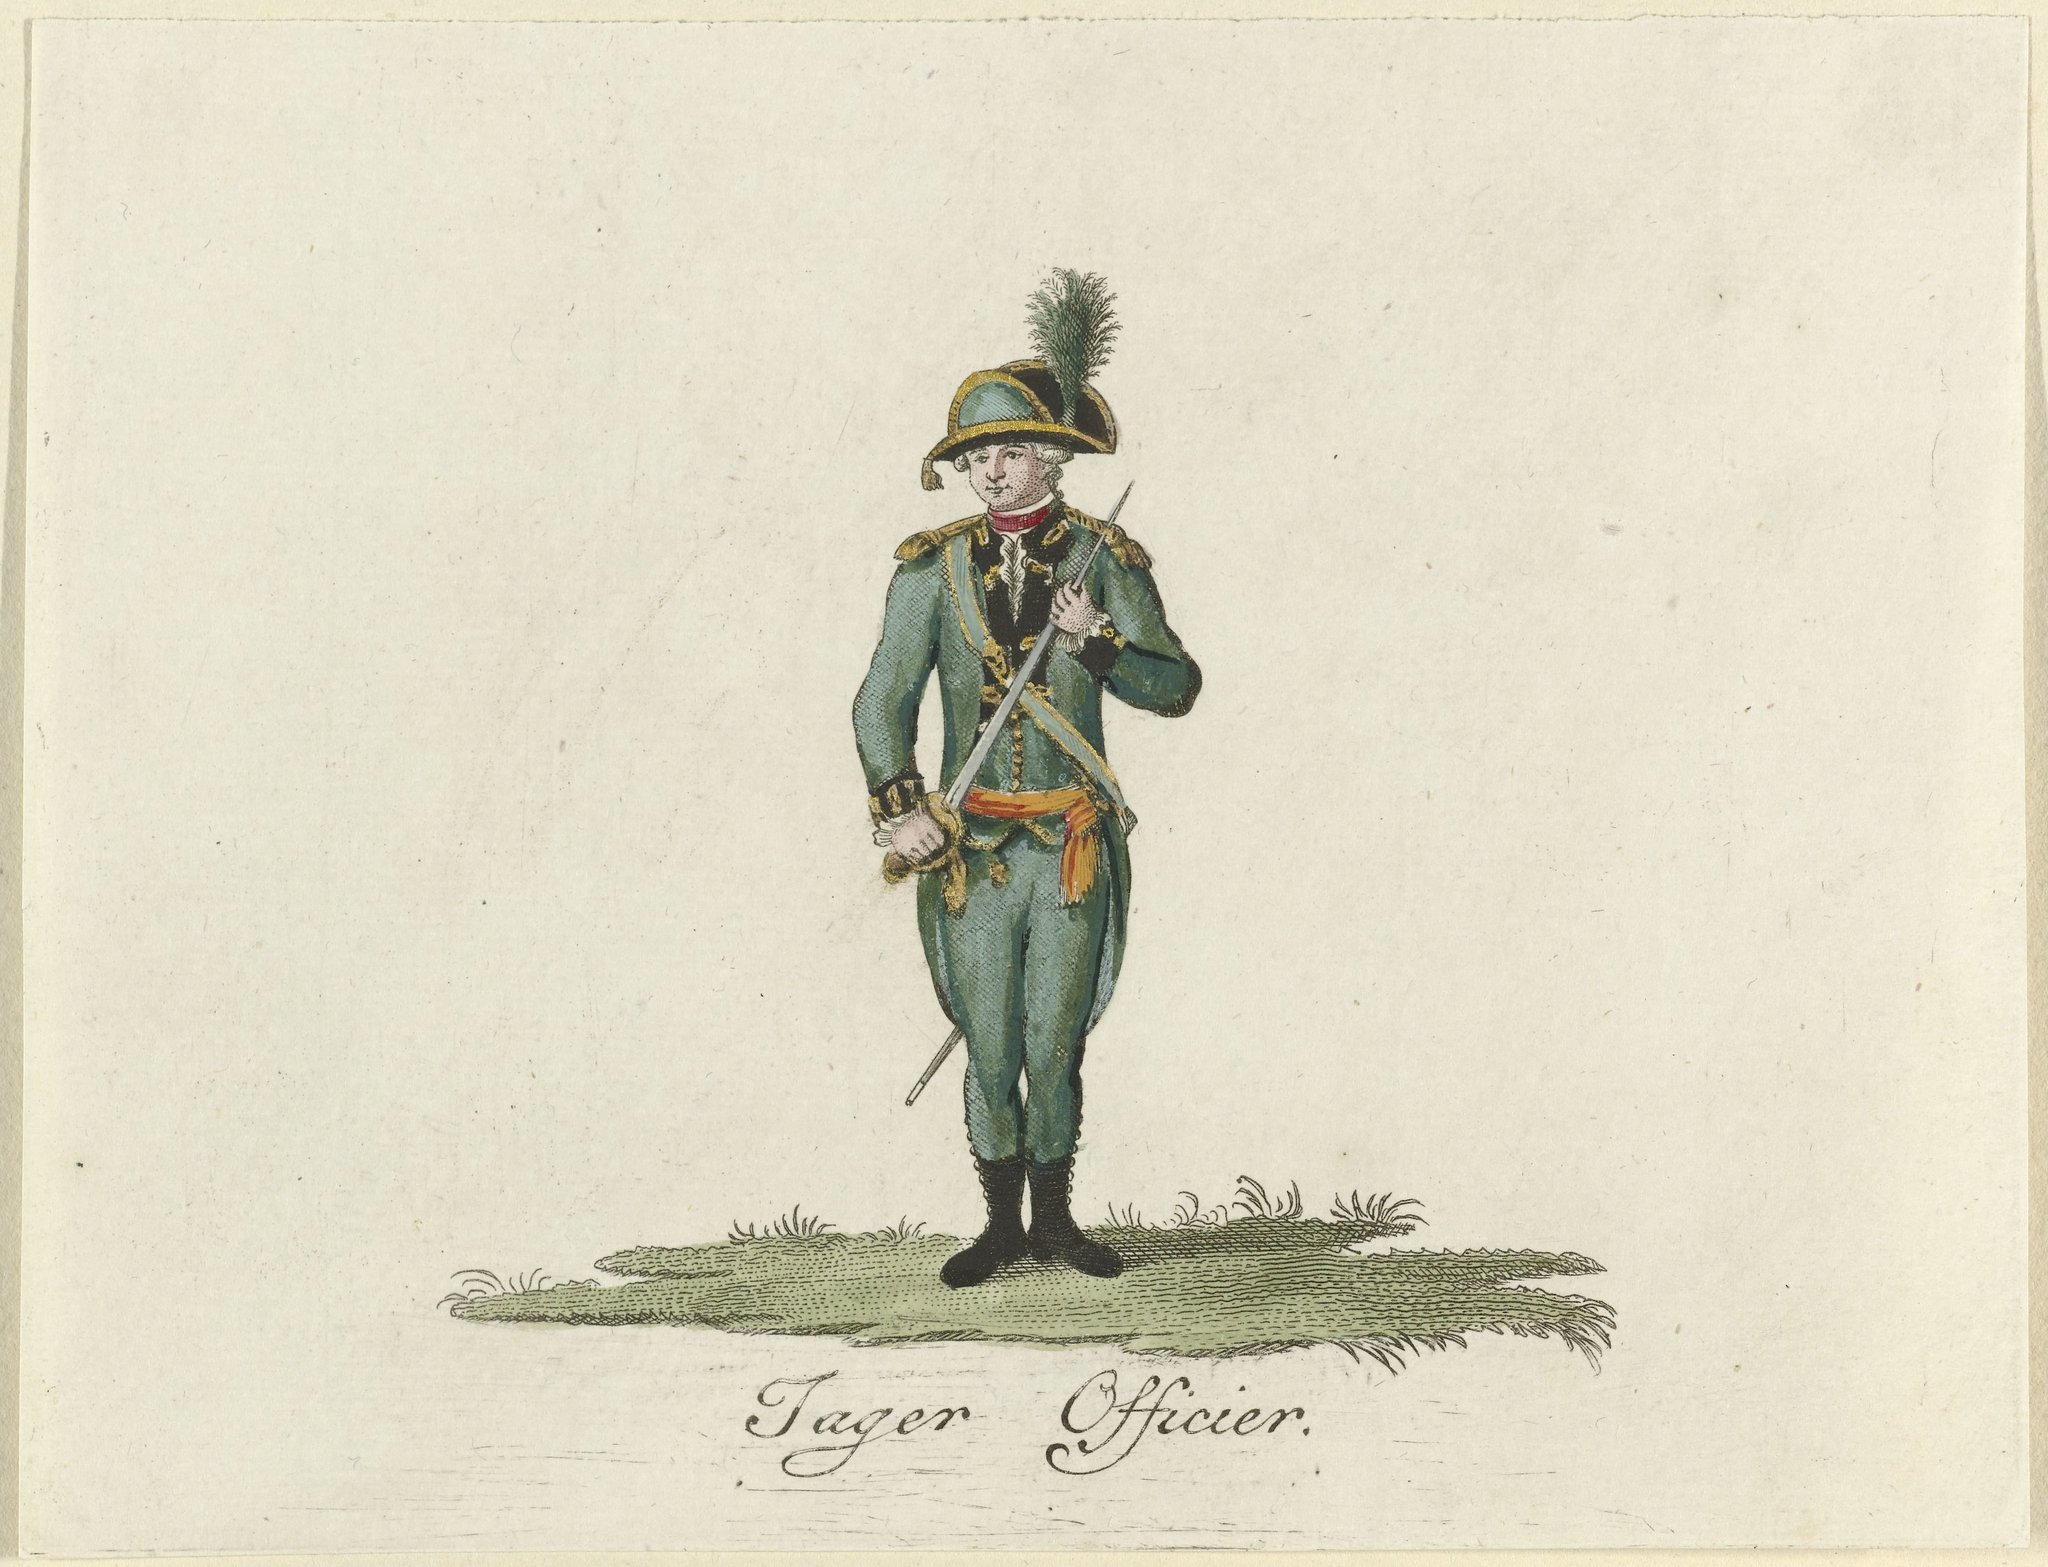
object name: costume print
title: Jager Officier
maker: Anonymous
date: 1785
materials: paper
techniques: etching, hand coloring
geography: northern netherlands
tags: rijngraaf van salm frederik iii, (military) uniforms (+ infantry), patriots (1780-1795)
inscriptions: collector's mark: Lugt 2228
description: Staande jager in uniform. Onderdeel van de prentserie van uniformen van het legioen van Frederik III Rijngraaf van Salm, in dienst van Republiek in 1785.